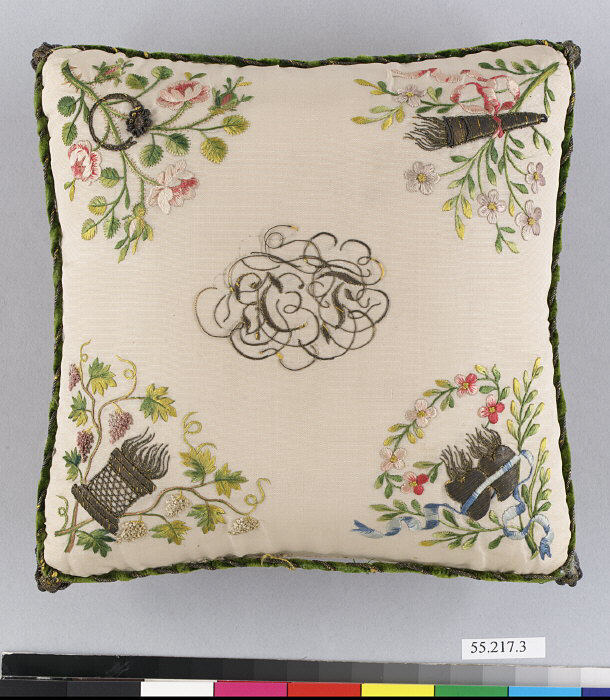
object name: cushion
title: Wedding ring cushion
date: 1851-1900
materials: metal thread, silk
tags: grapes,flowers